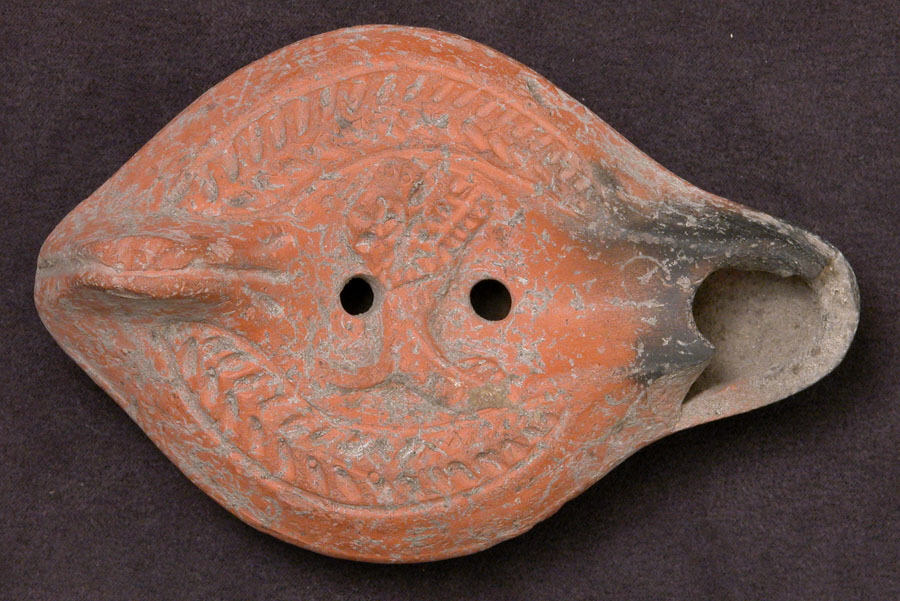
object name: lamp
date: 301-400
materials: earthenware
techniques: molding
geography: egypt